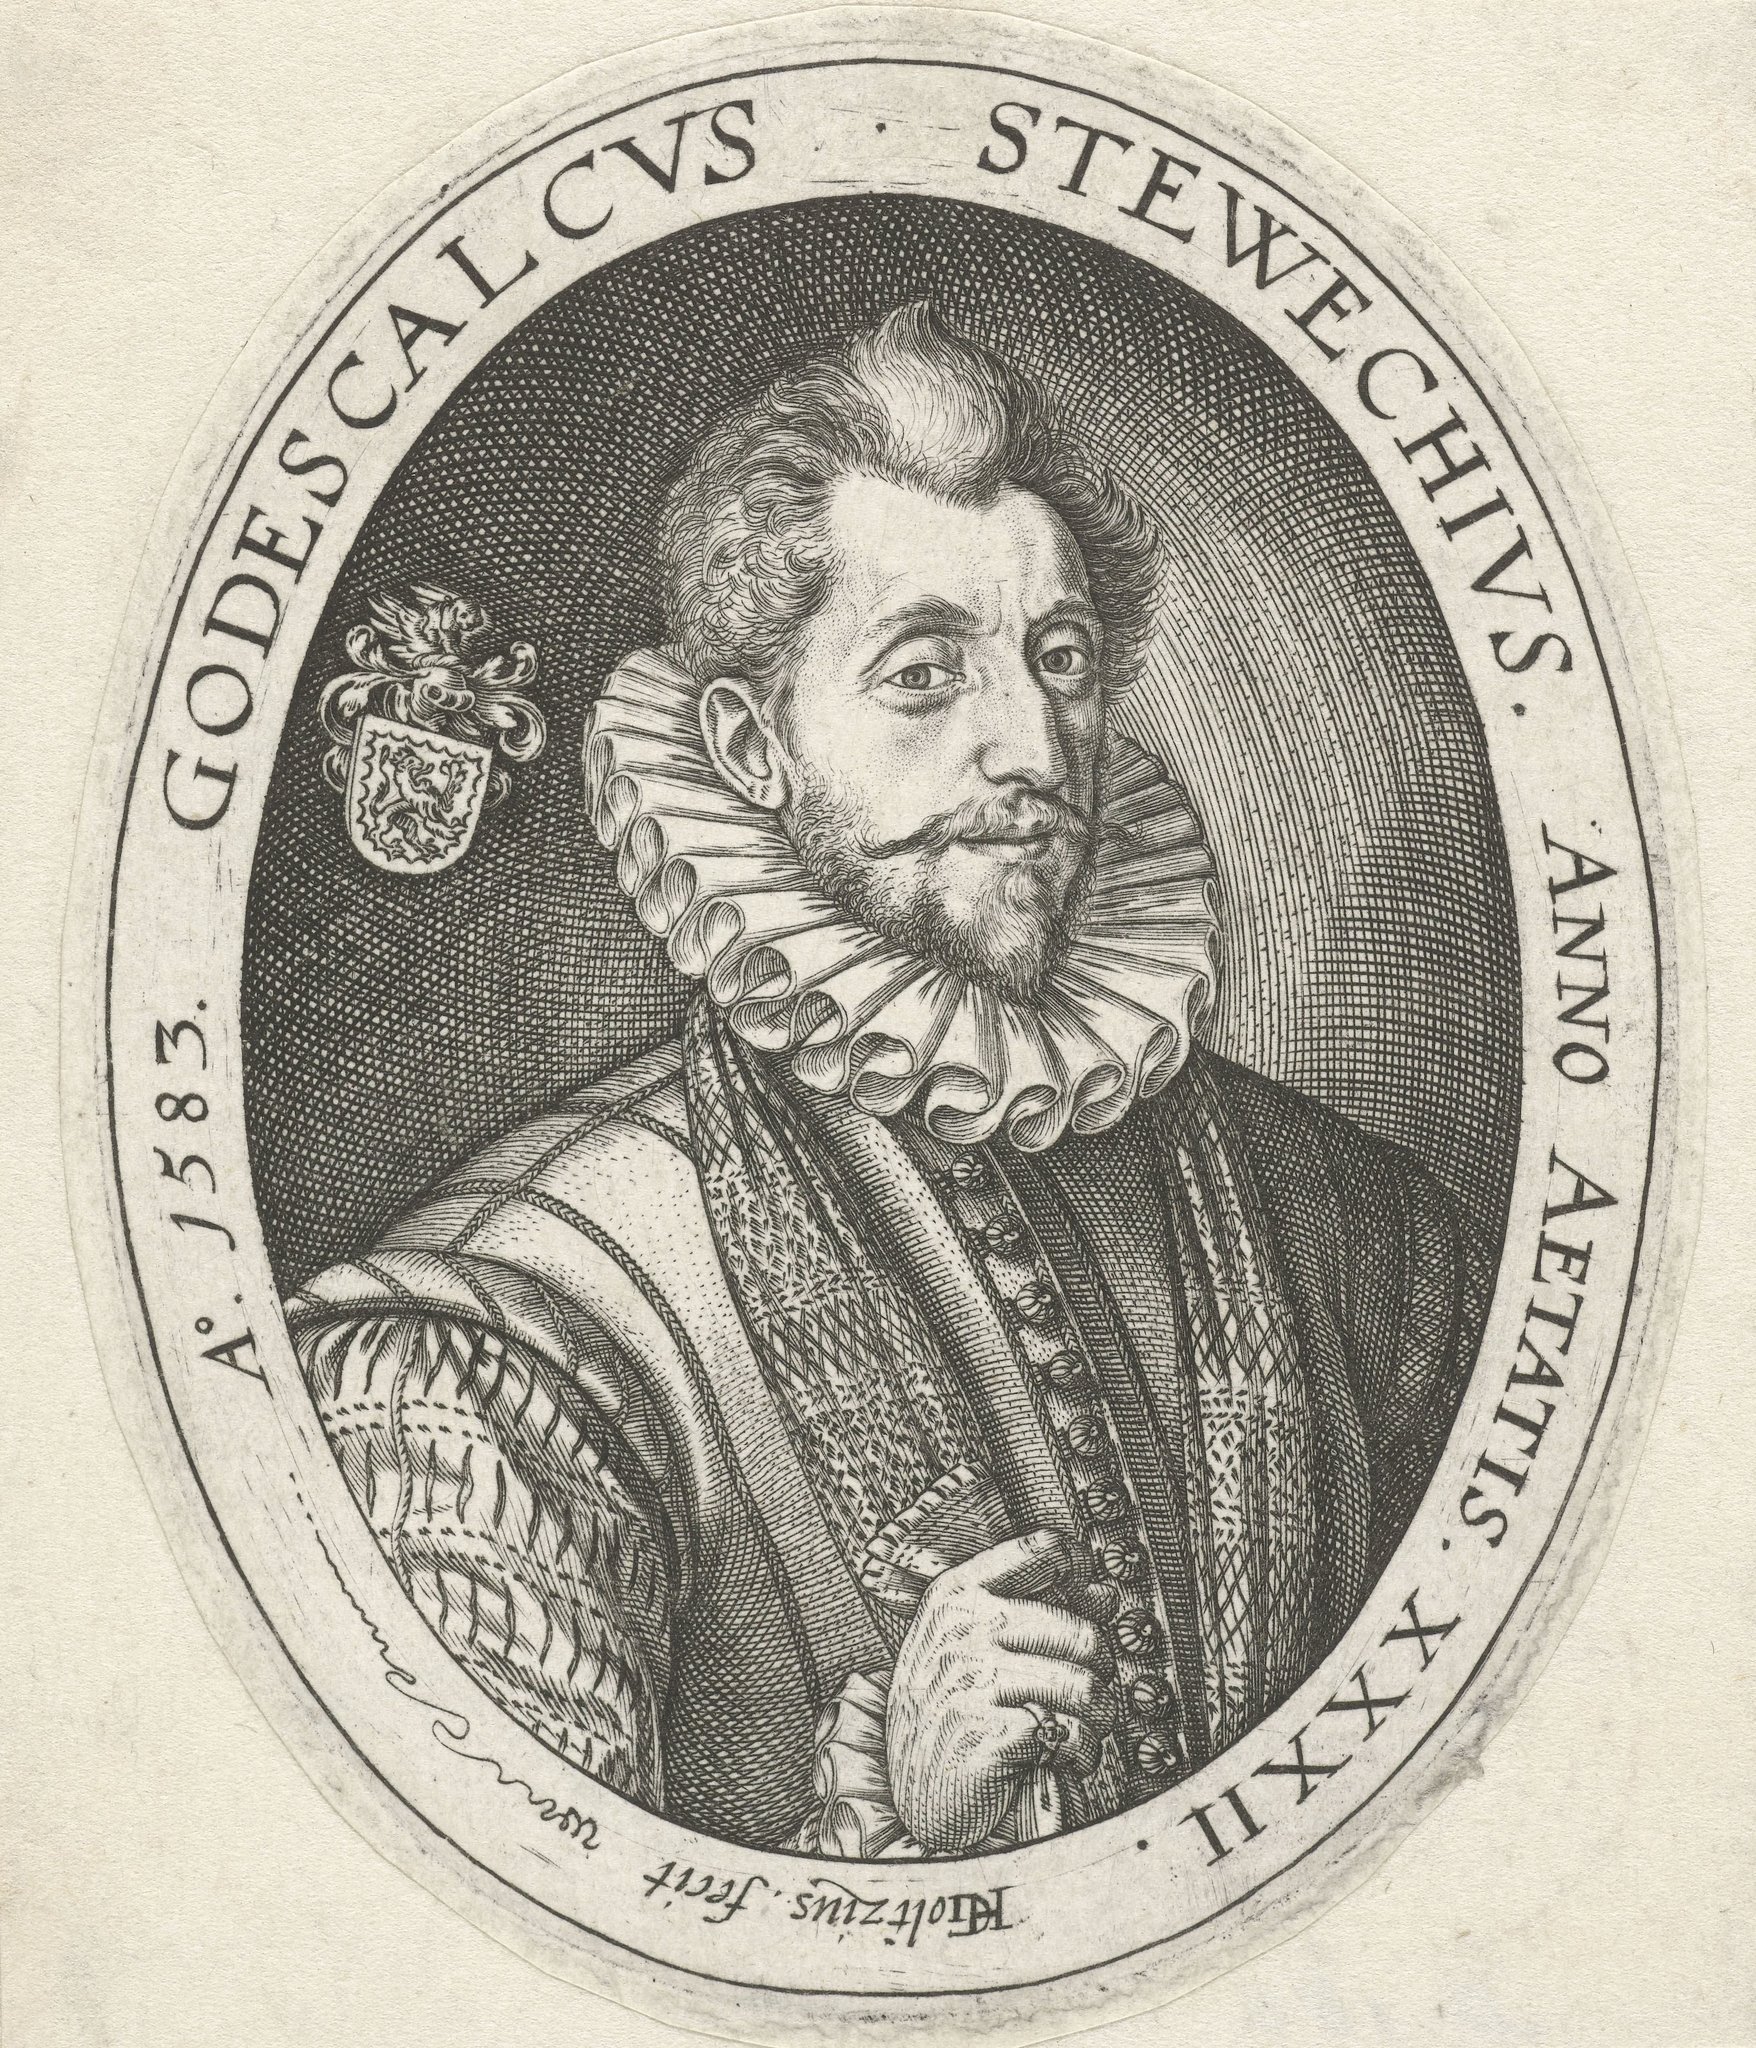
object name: print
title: Portret van Godescalcus Stewechius op 32-jarige leeftijd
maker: hendrick goltzius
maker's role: draughtsman, painter, print maker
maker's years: 1558-1617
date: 1583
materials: paper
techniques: engraving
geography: haarlem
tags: gloves, mittens, etc., neck-gear ~ clothing (with name)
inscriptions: collector's mark: Lugt 240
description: Portret van de taalkundige Godelscalcus Stewechius ten halven lijve, in ovaal met randschrift. Naast het hoofd het familiewapen van Stewechius.